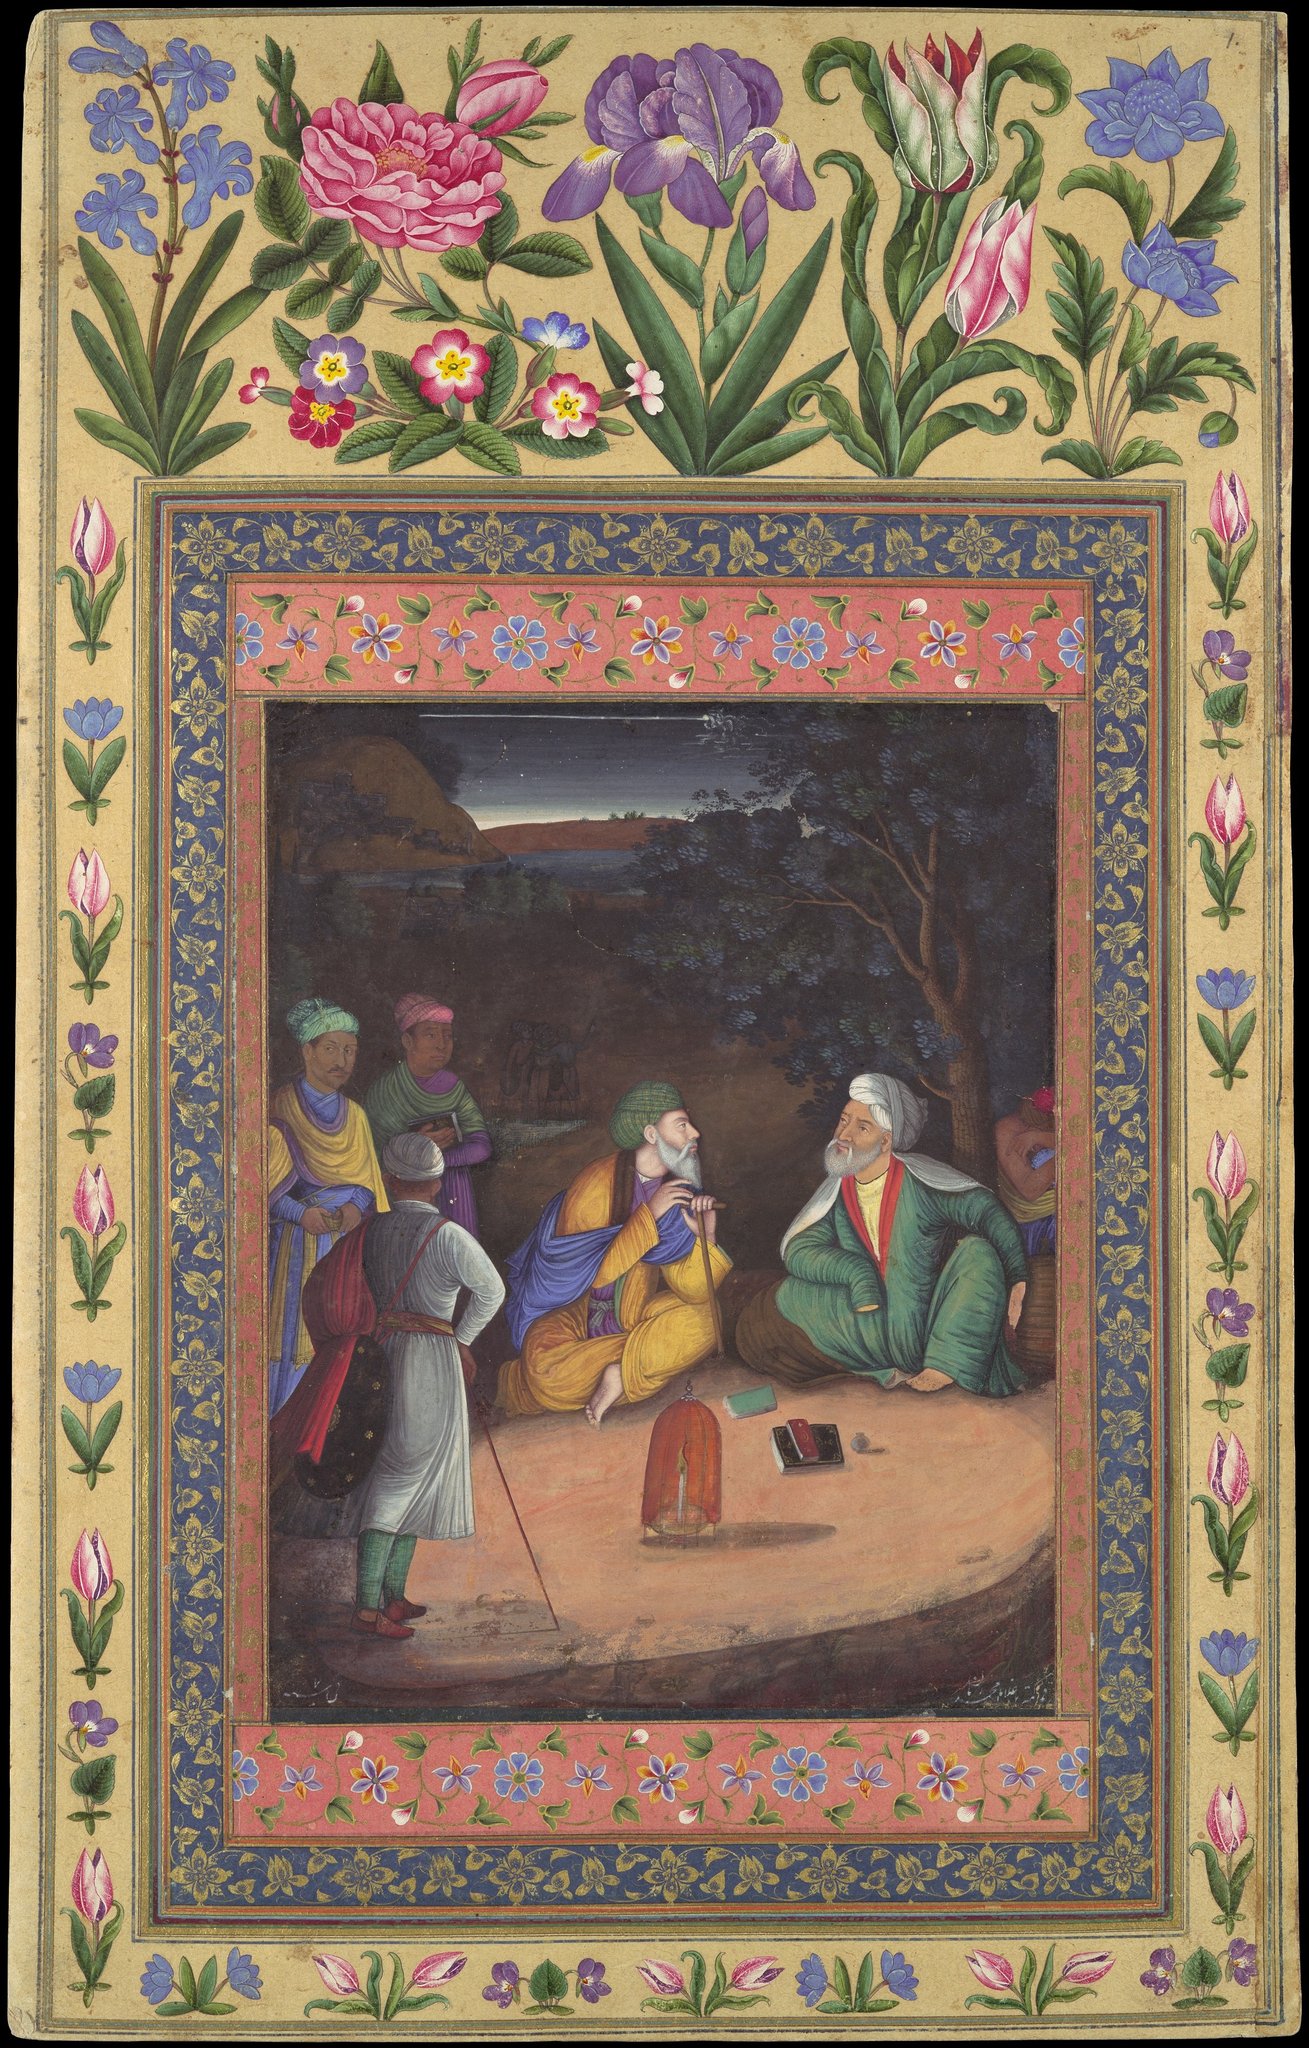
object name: illustrated album leaf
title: "A Night-time Gathering", Folio from the Davis Album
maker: muhammad zaman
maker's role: artist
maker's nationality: iranian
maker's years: 1624-1725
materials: gold, ink, paper, watercolor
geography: india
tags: men,flowers,leaves,night